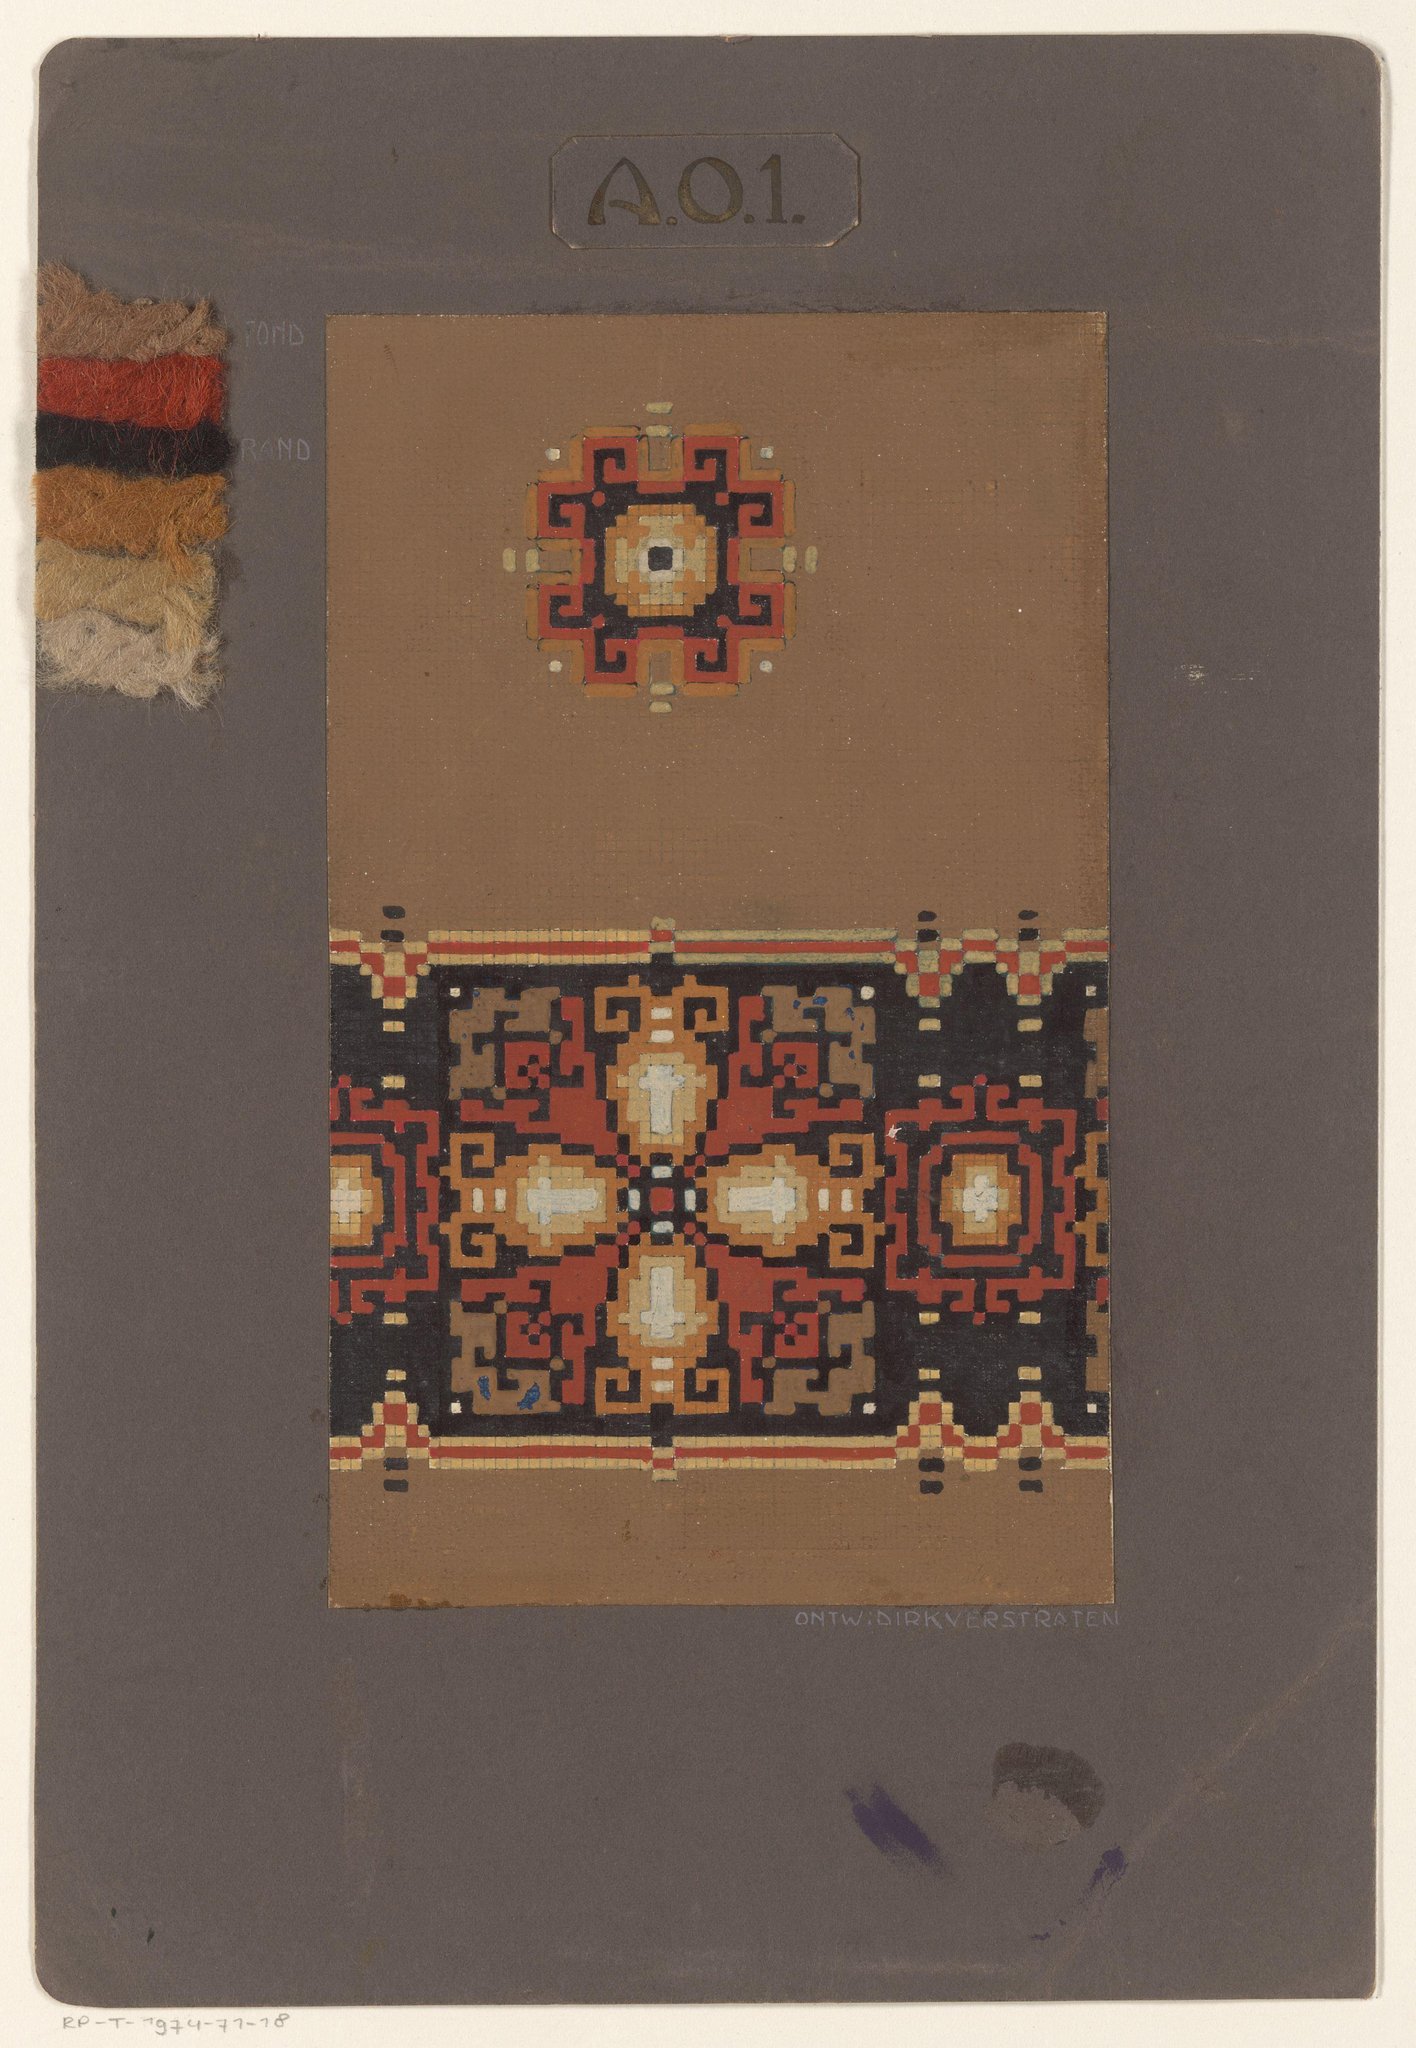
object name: design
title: Ontwerp voor de rand van een tapijt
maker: dirk verstraten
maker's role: designer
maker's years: 1892-1946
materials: cardboard, paint, paper, wool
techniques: brush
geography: amsterdam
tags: ornaments ~ art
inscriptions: label: ‘GELDIG/ voor/ T WOONHUYS"/ Tot 1 DEC '24’, collector's mark: ‘R:MVS’, number: ‘A.0.1’, number: ‘15.’, inscription: ‘ROND/ RAND’